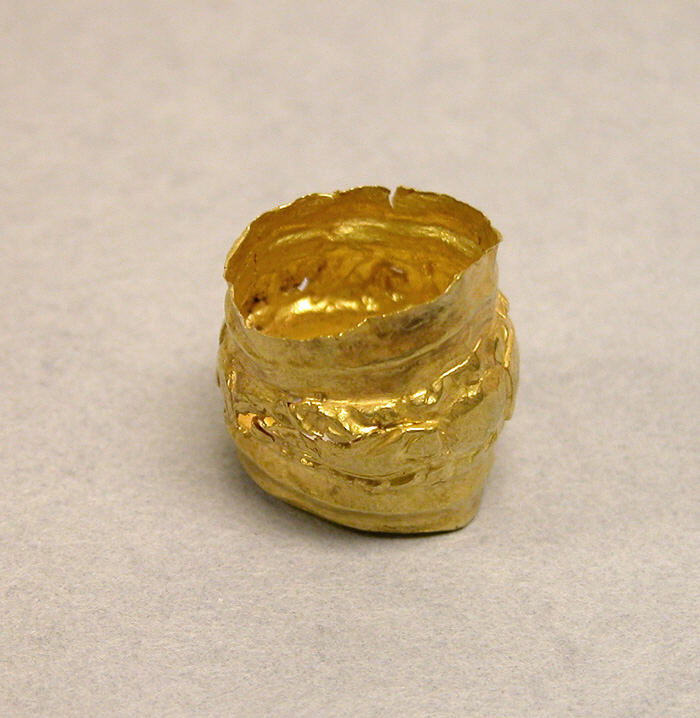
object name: ornament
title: Ornamental Band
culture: indonesian, central java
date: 701-1200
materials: gold